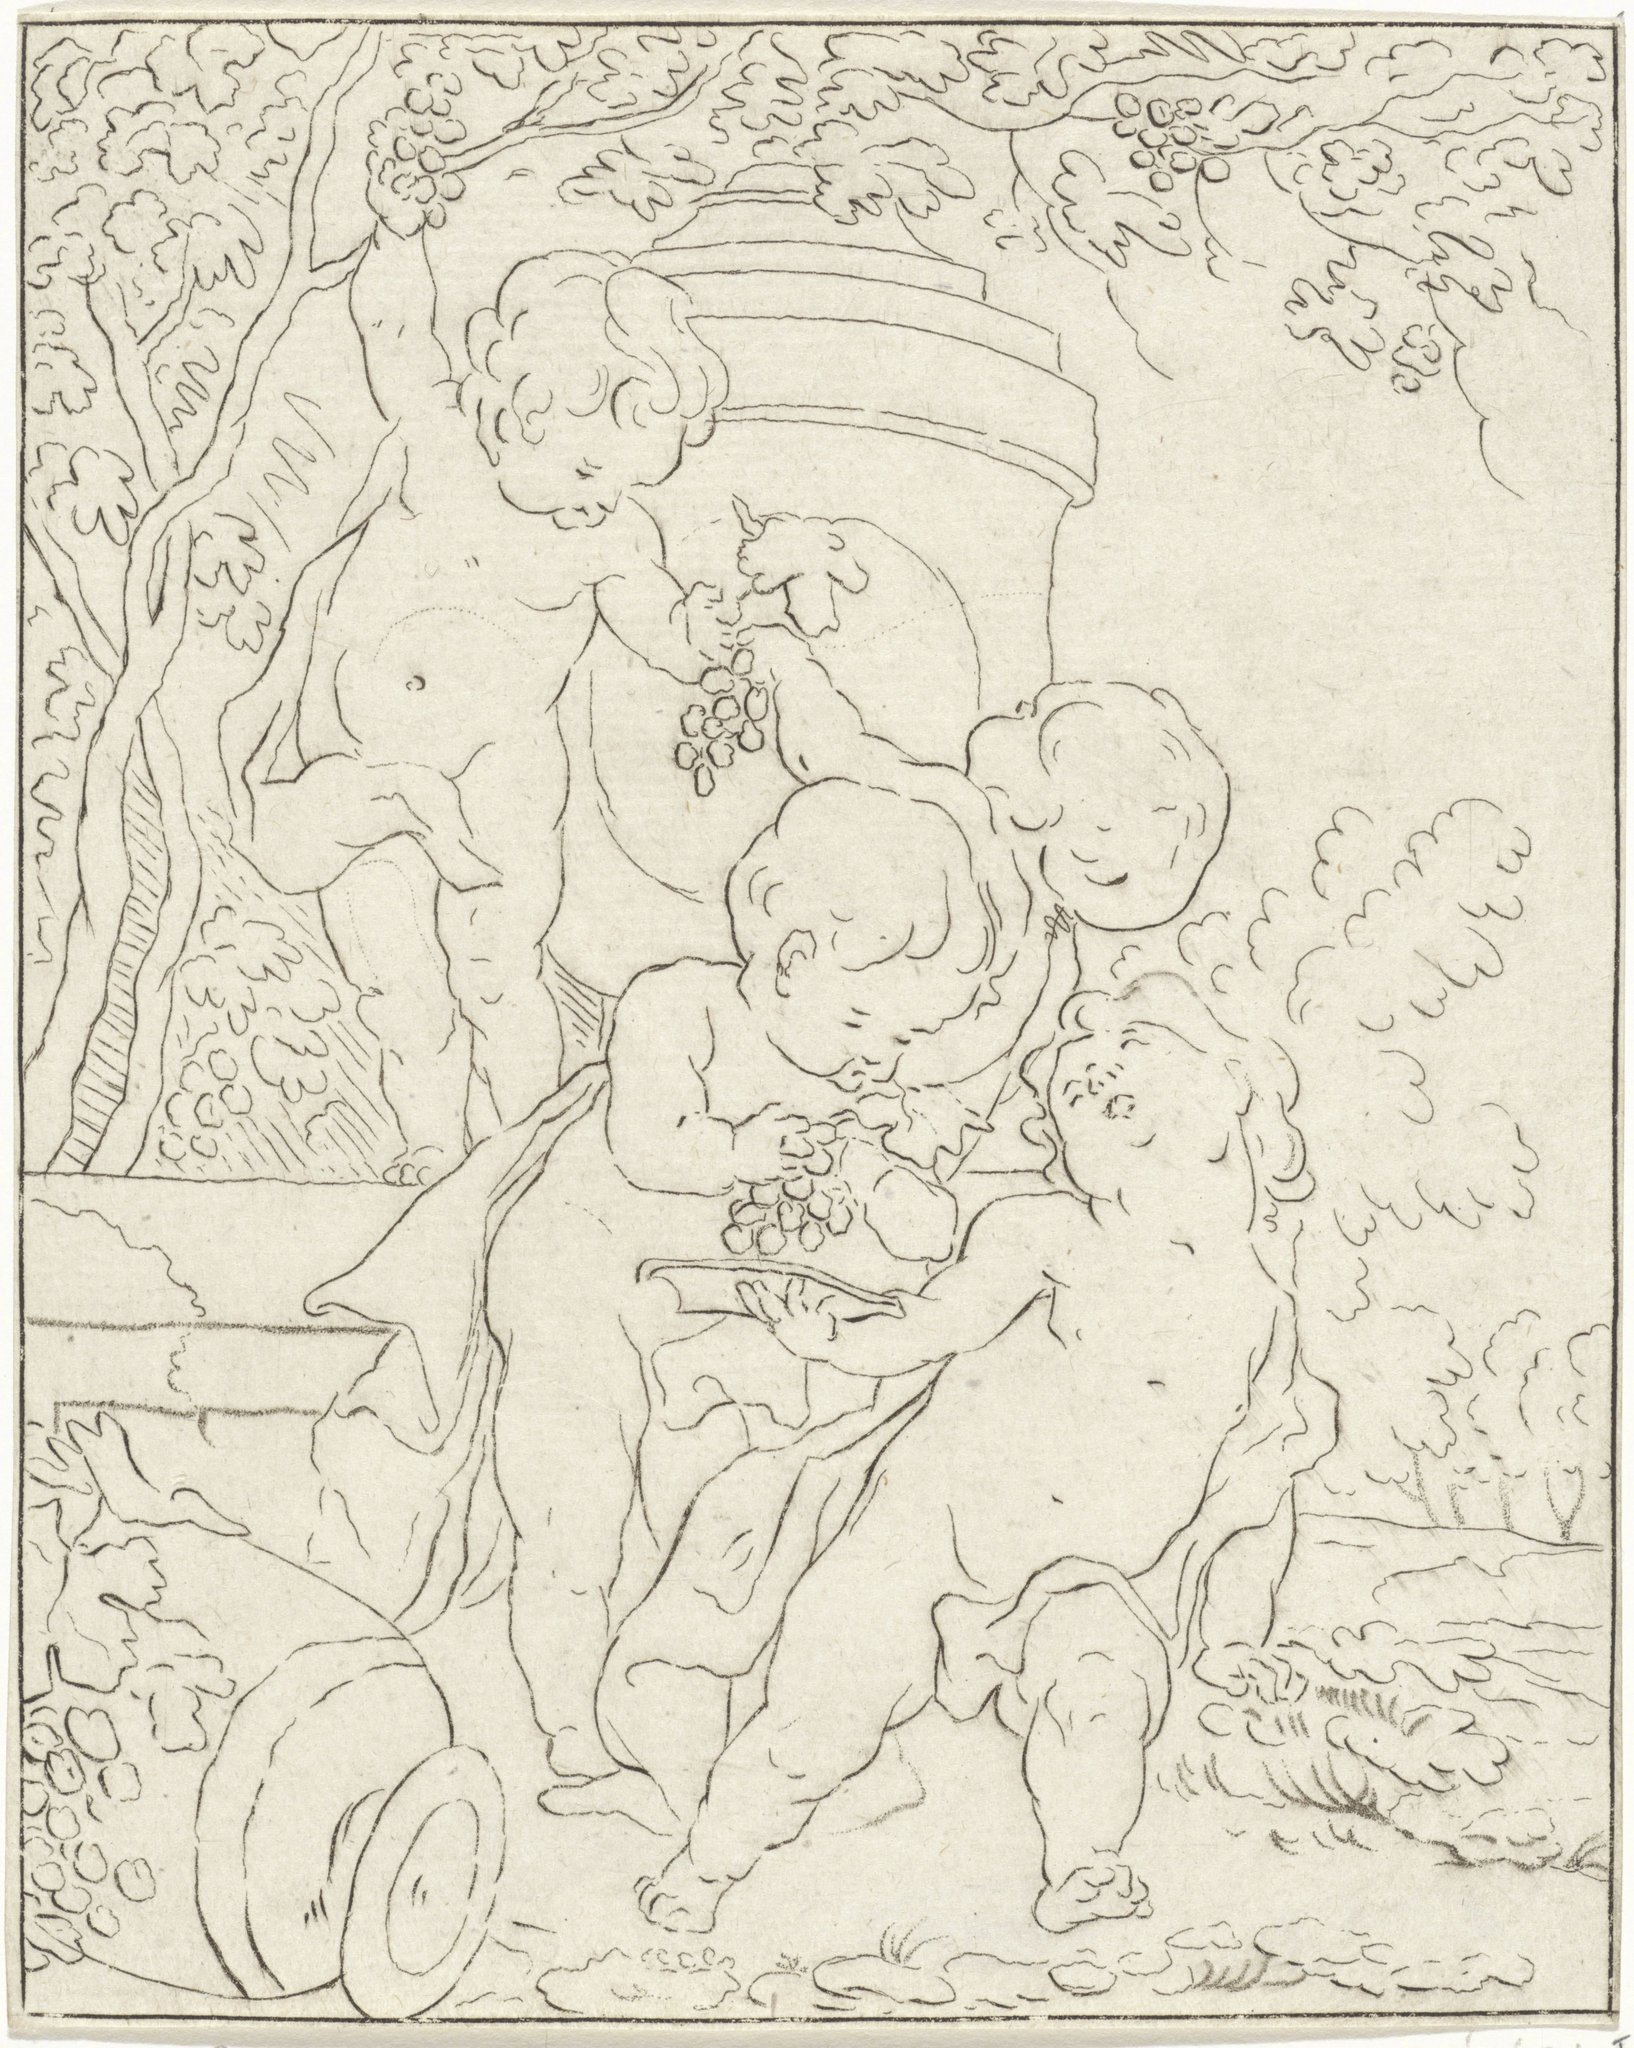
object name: print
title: Vier druiven plukkende putti bij een vaas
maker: bernhard schreuder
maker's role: print maker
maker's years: -1780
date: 1767-1780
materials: paper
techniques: etching, roulette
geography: netherlands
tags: cupids: 'amores', 'amoretti', 'putti', bunch of grapes, garden vase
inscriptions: collector's mark: Lugt 2228